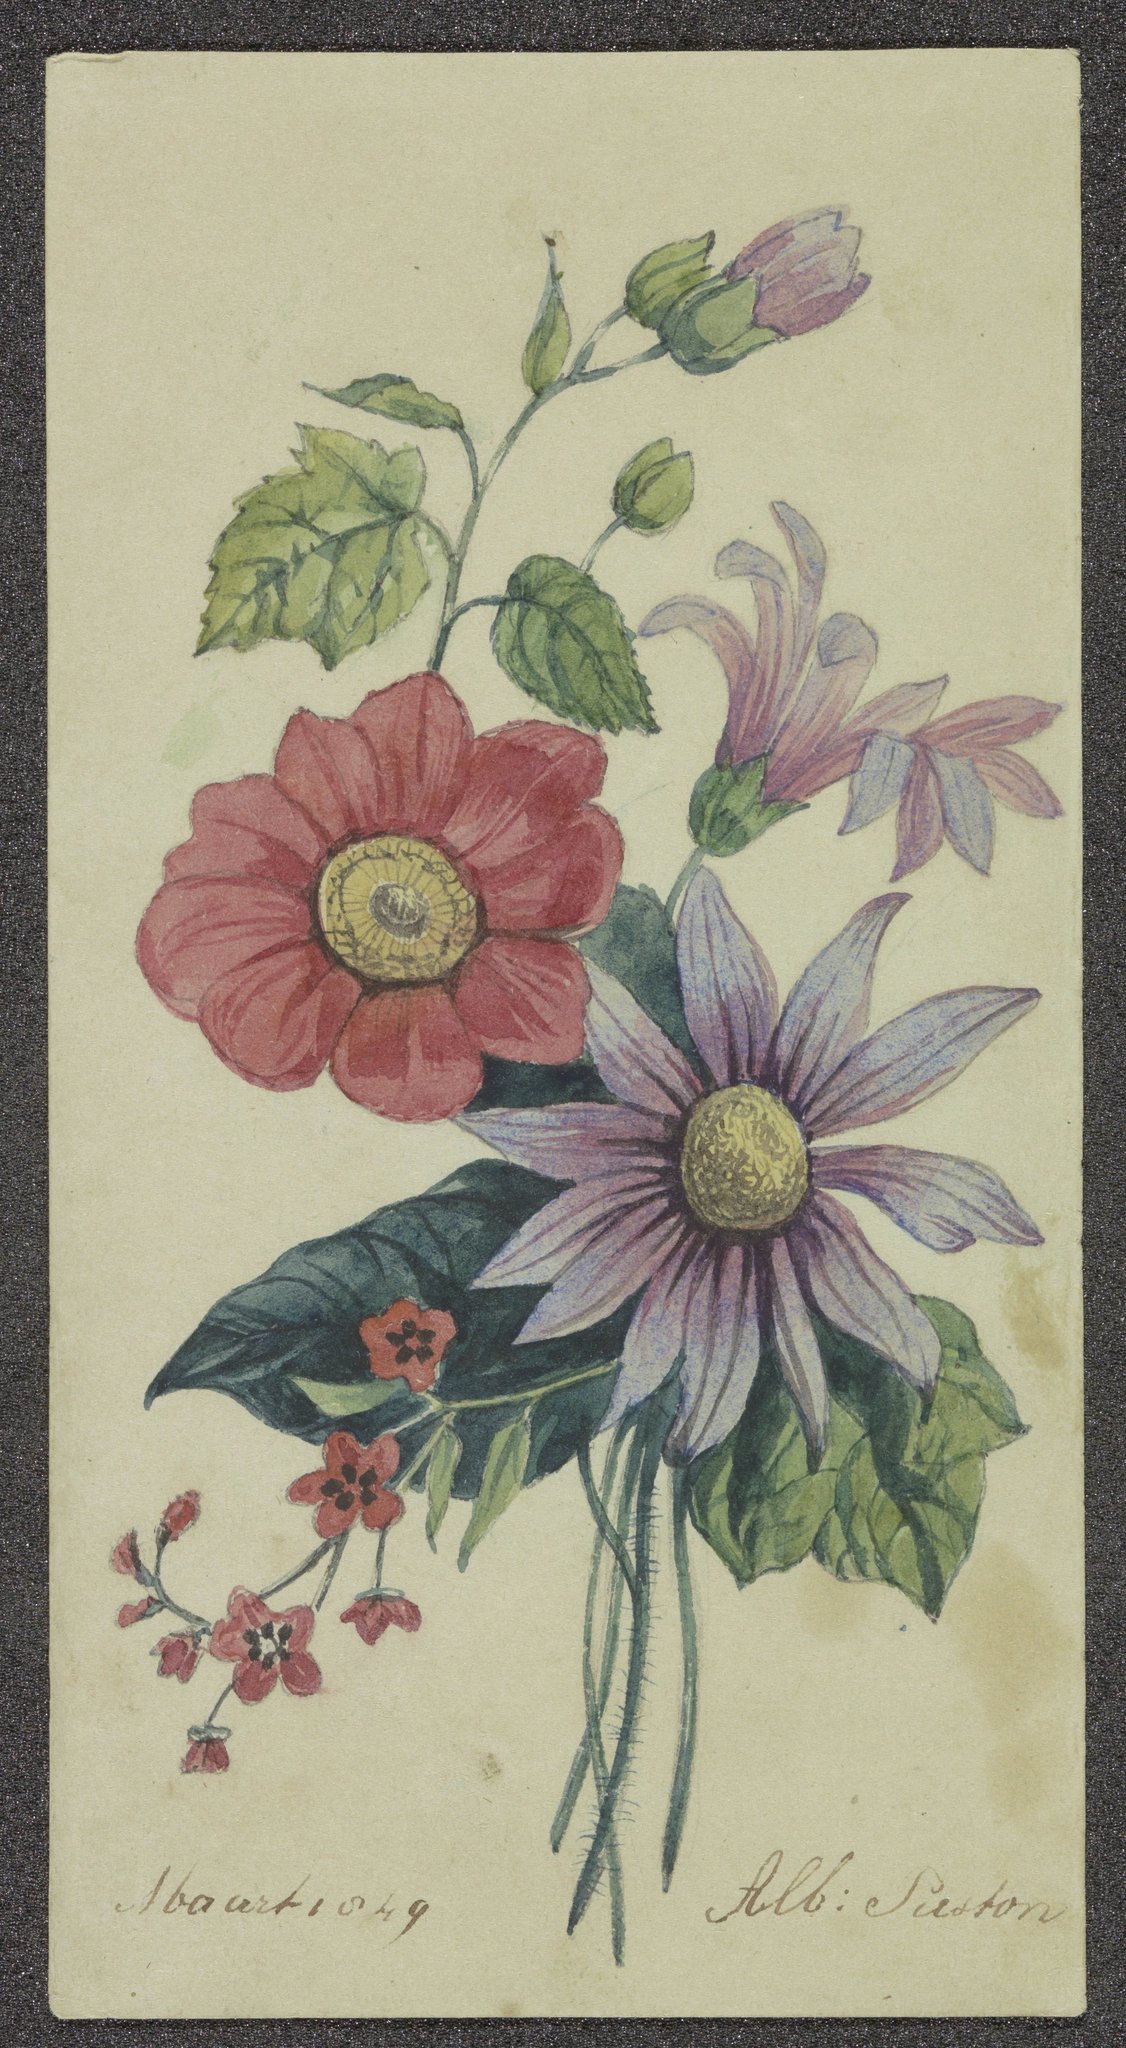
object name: album leaf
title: Bloemen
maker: Anonymous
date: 1803-1849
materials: paper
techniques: brush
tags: flowers, 'album amicorum', 'stammbuch'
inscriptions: date